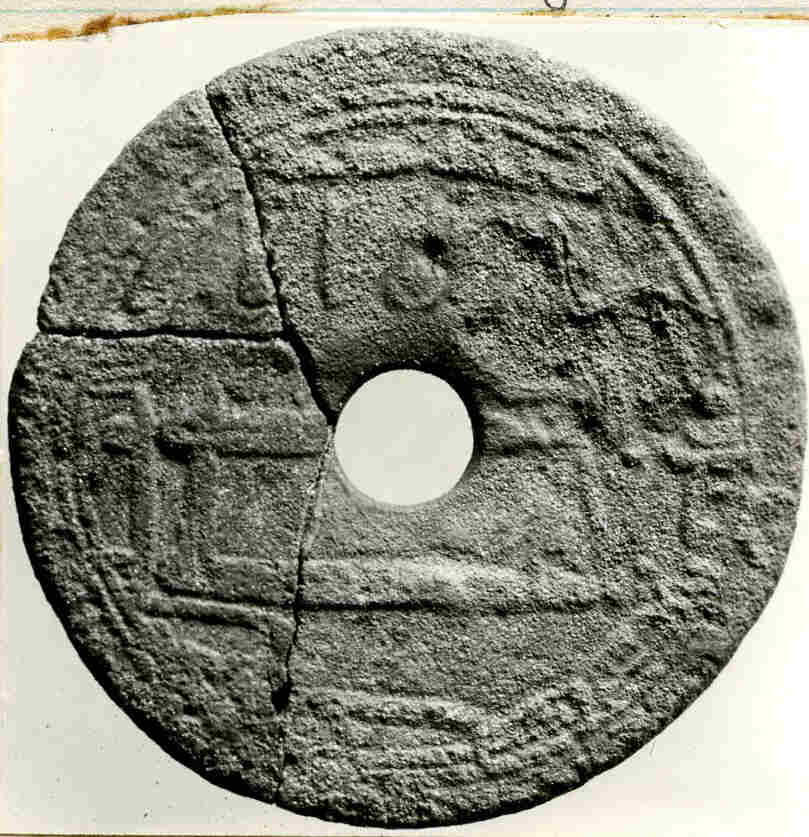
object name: coin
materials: copper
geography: al-rafiqa